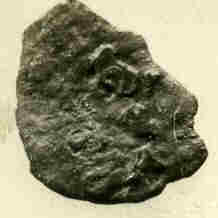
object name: coin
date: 401-1400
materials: copper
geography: iran